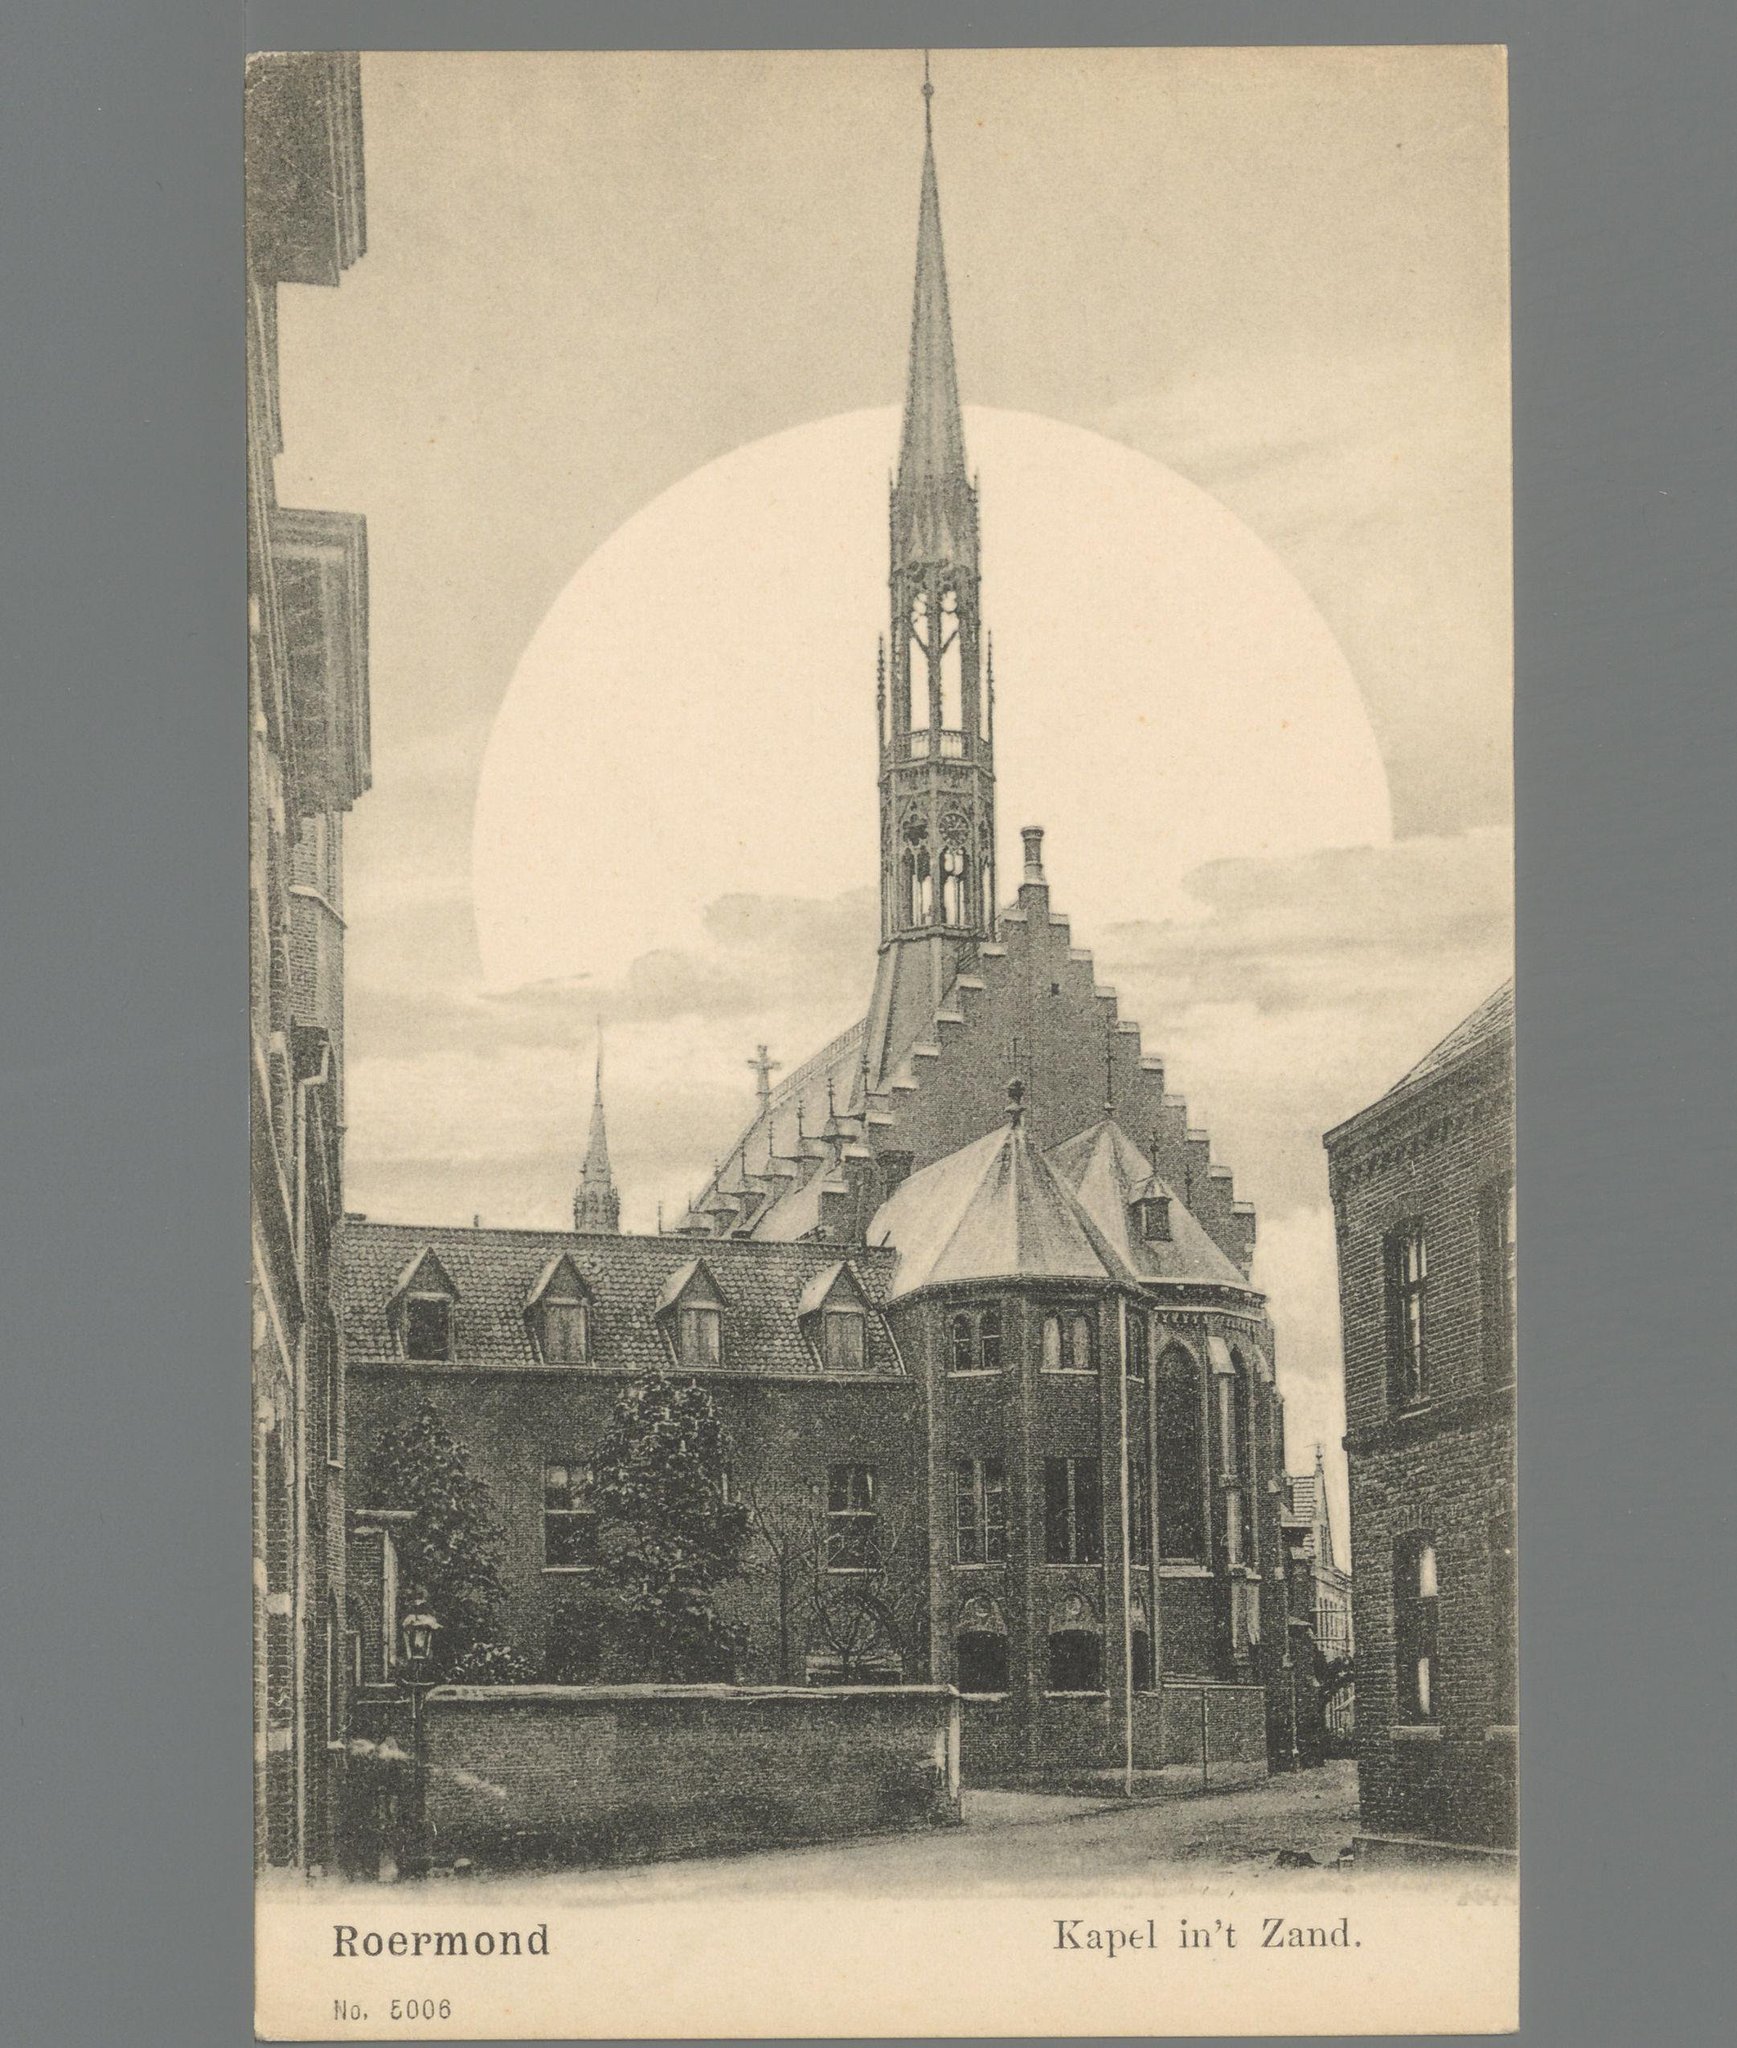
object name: ansichtkaart, prentbriefkaart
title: Roermond. Kapel in't Zand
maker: Anonymous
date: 1892-1905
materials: cardboard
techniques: photograph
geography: roermond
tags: full moon, church (exterior) - qq - small church, chapel